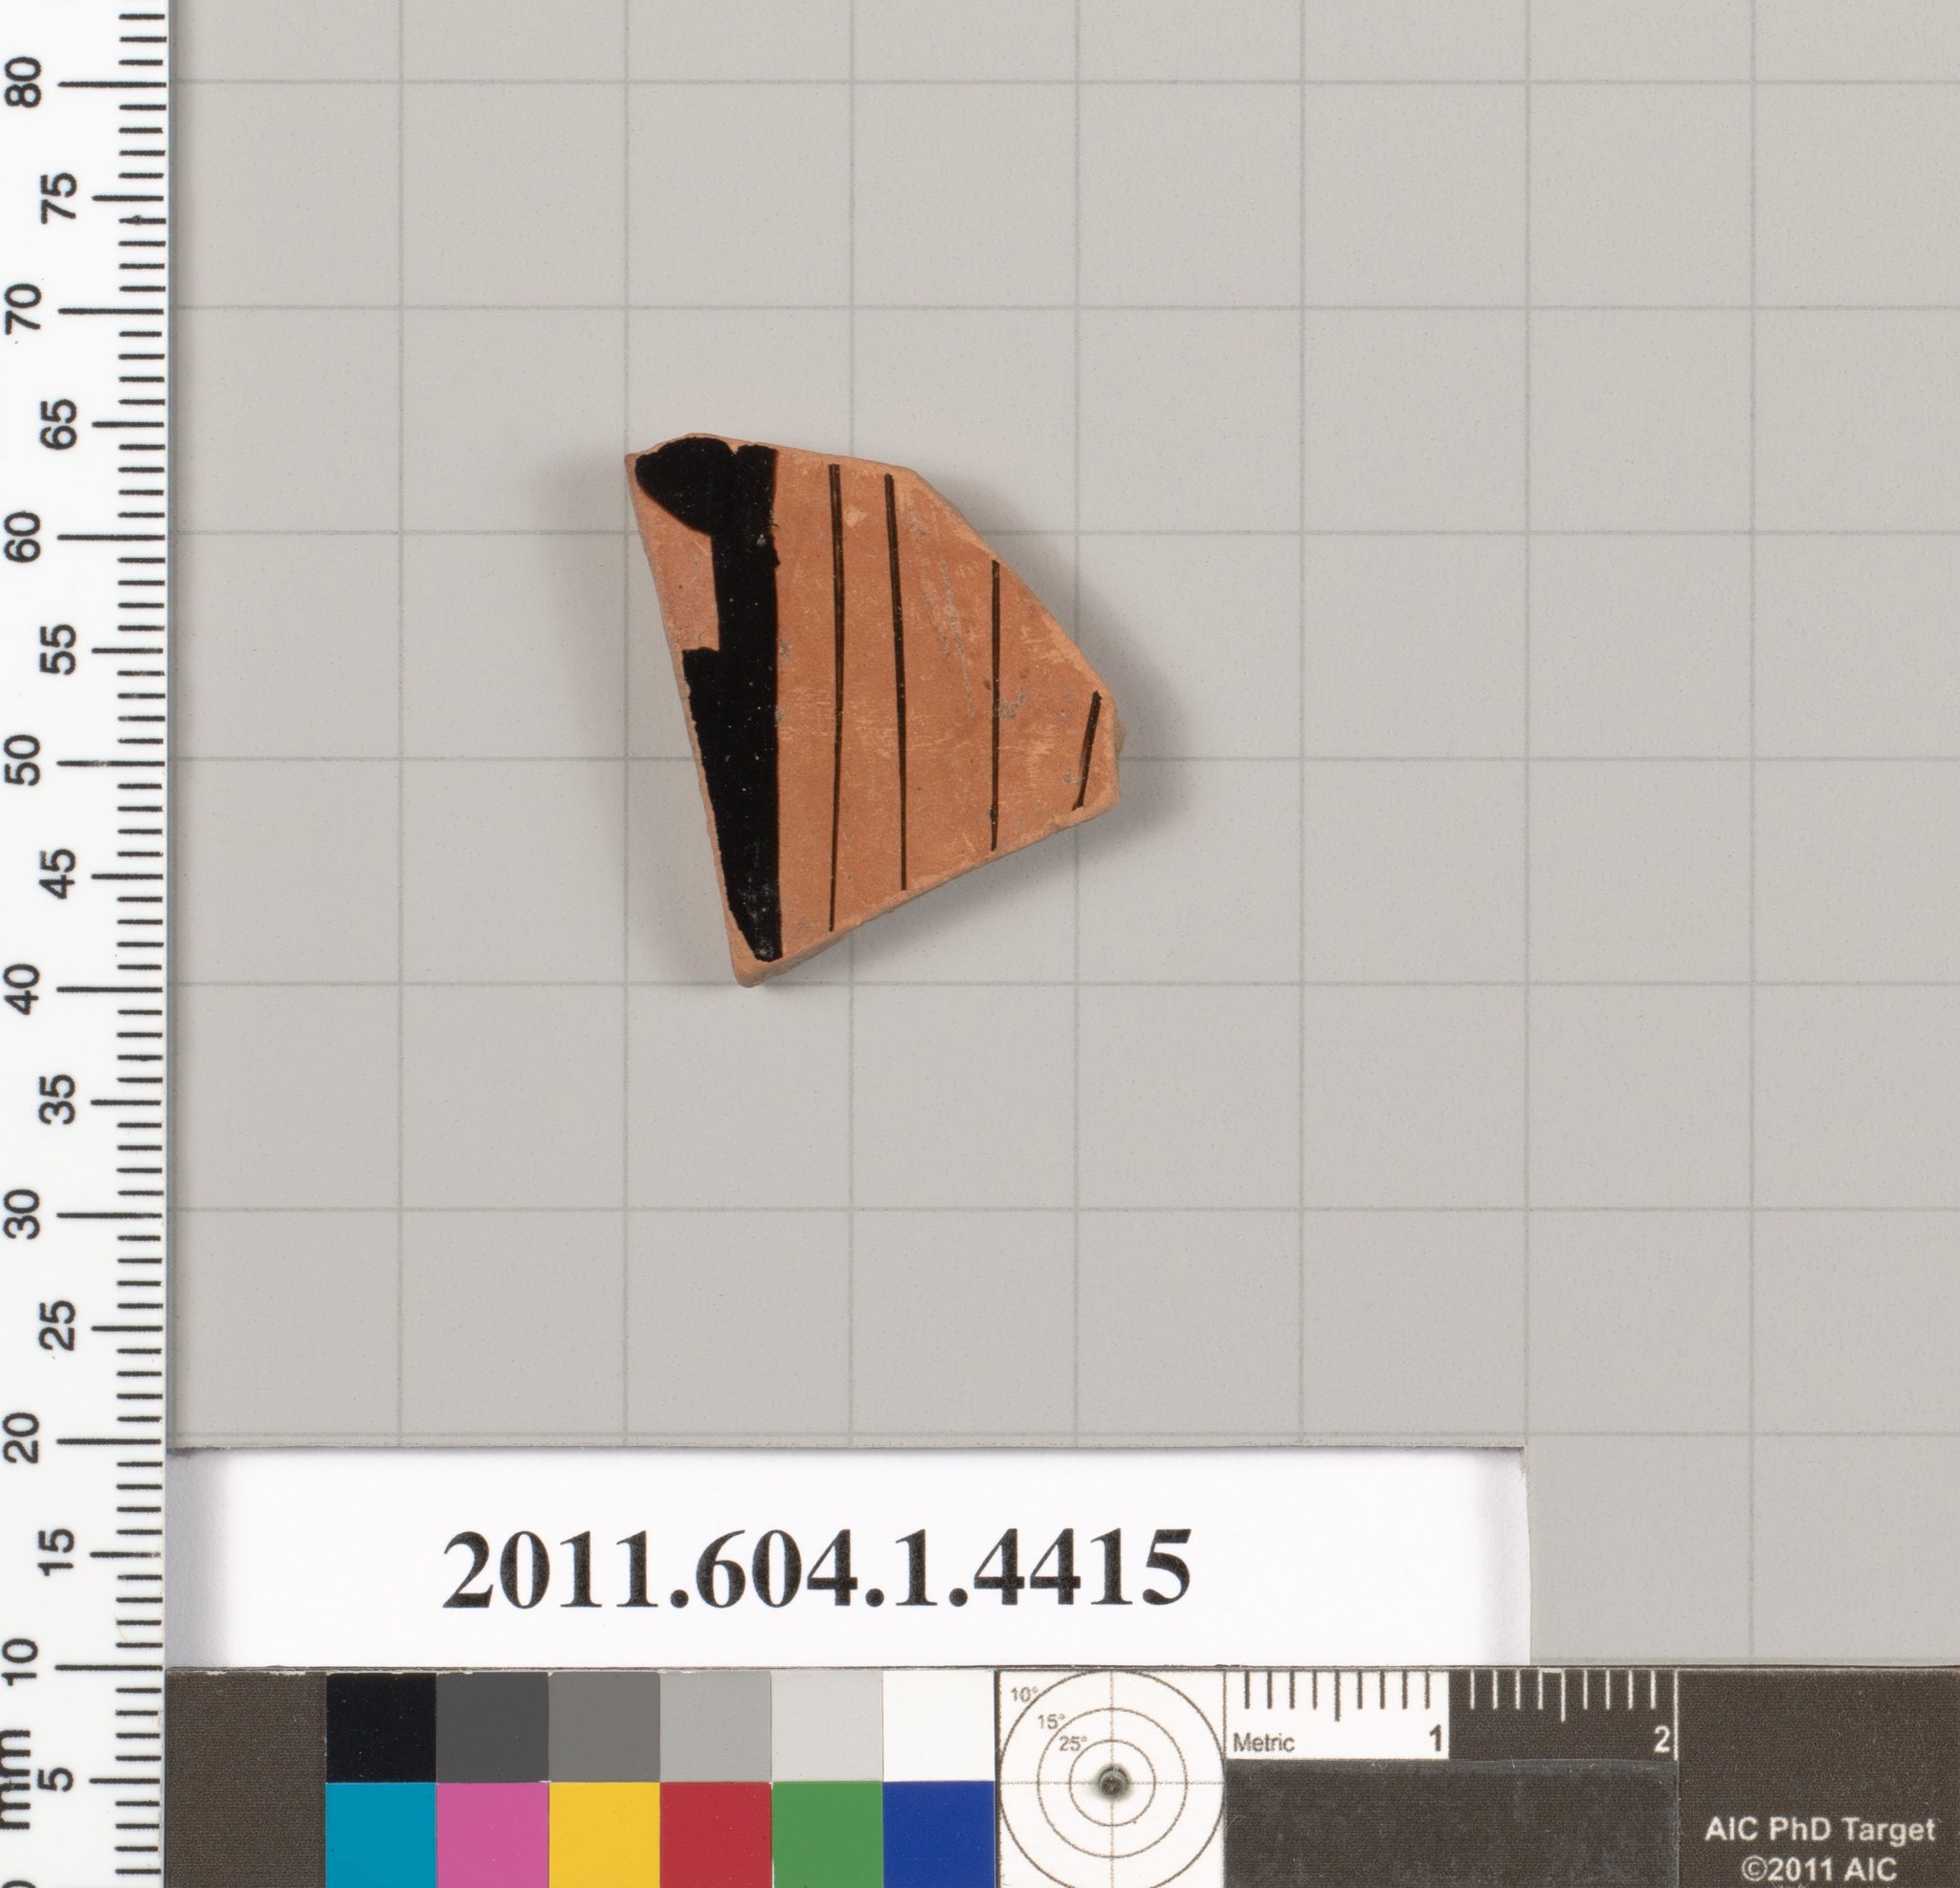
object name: kylix fragment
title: Terracotta fragment of a kylix (drinking cup)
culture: greek, attic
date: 490-470 BCE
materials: terracotta